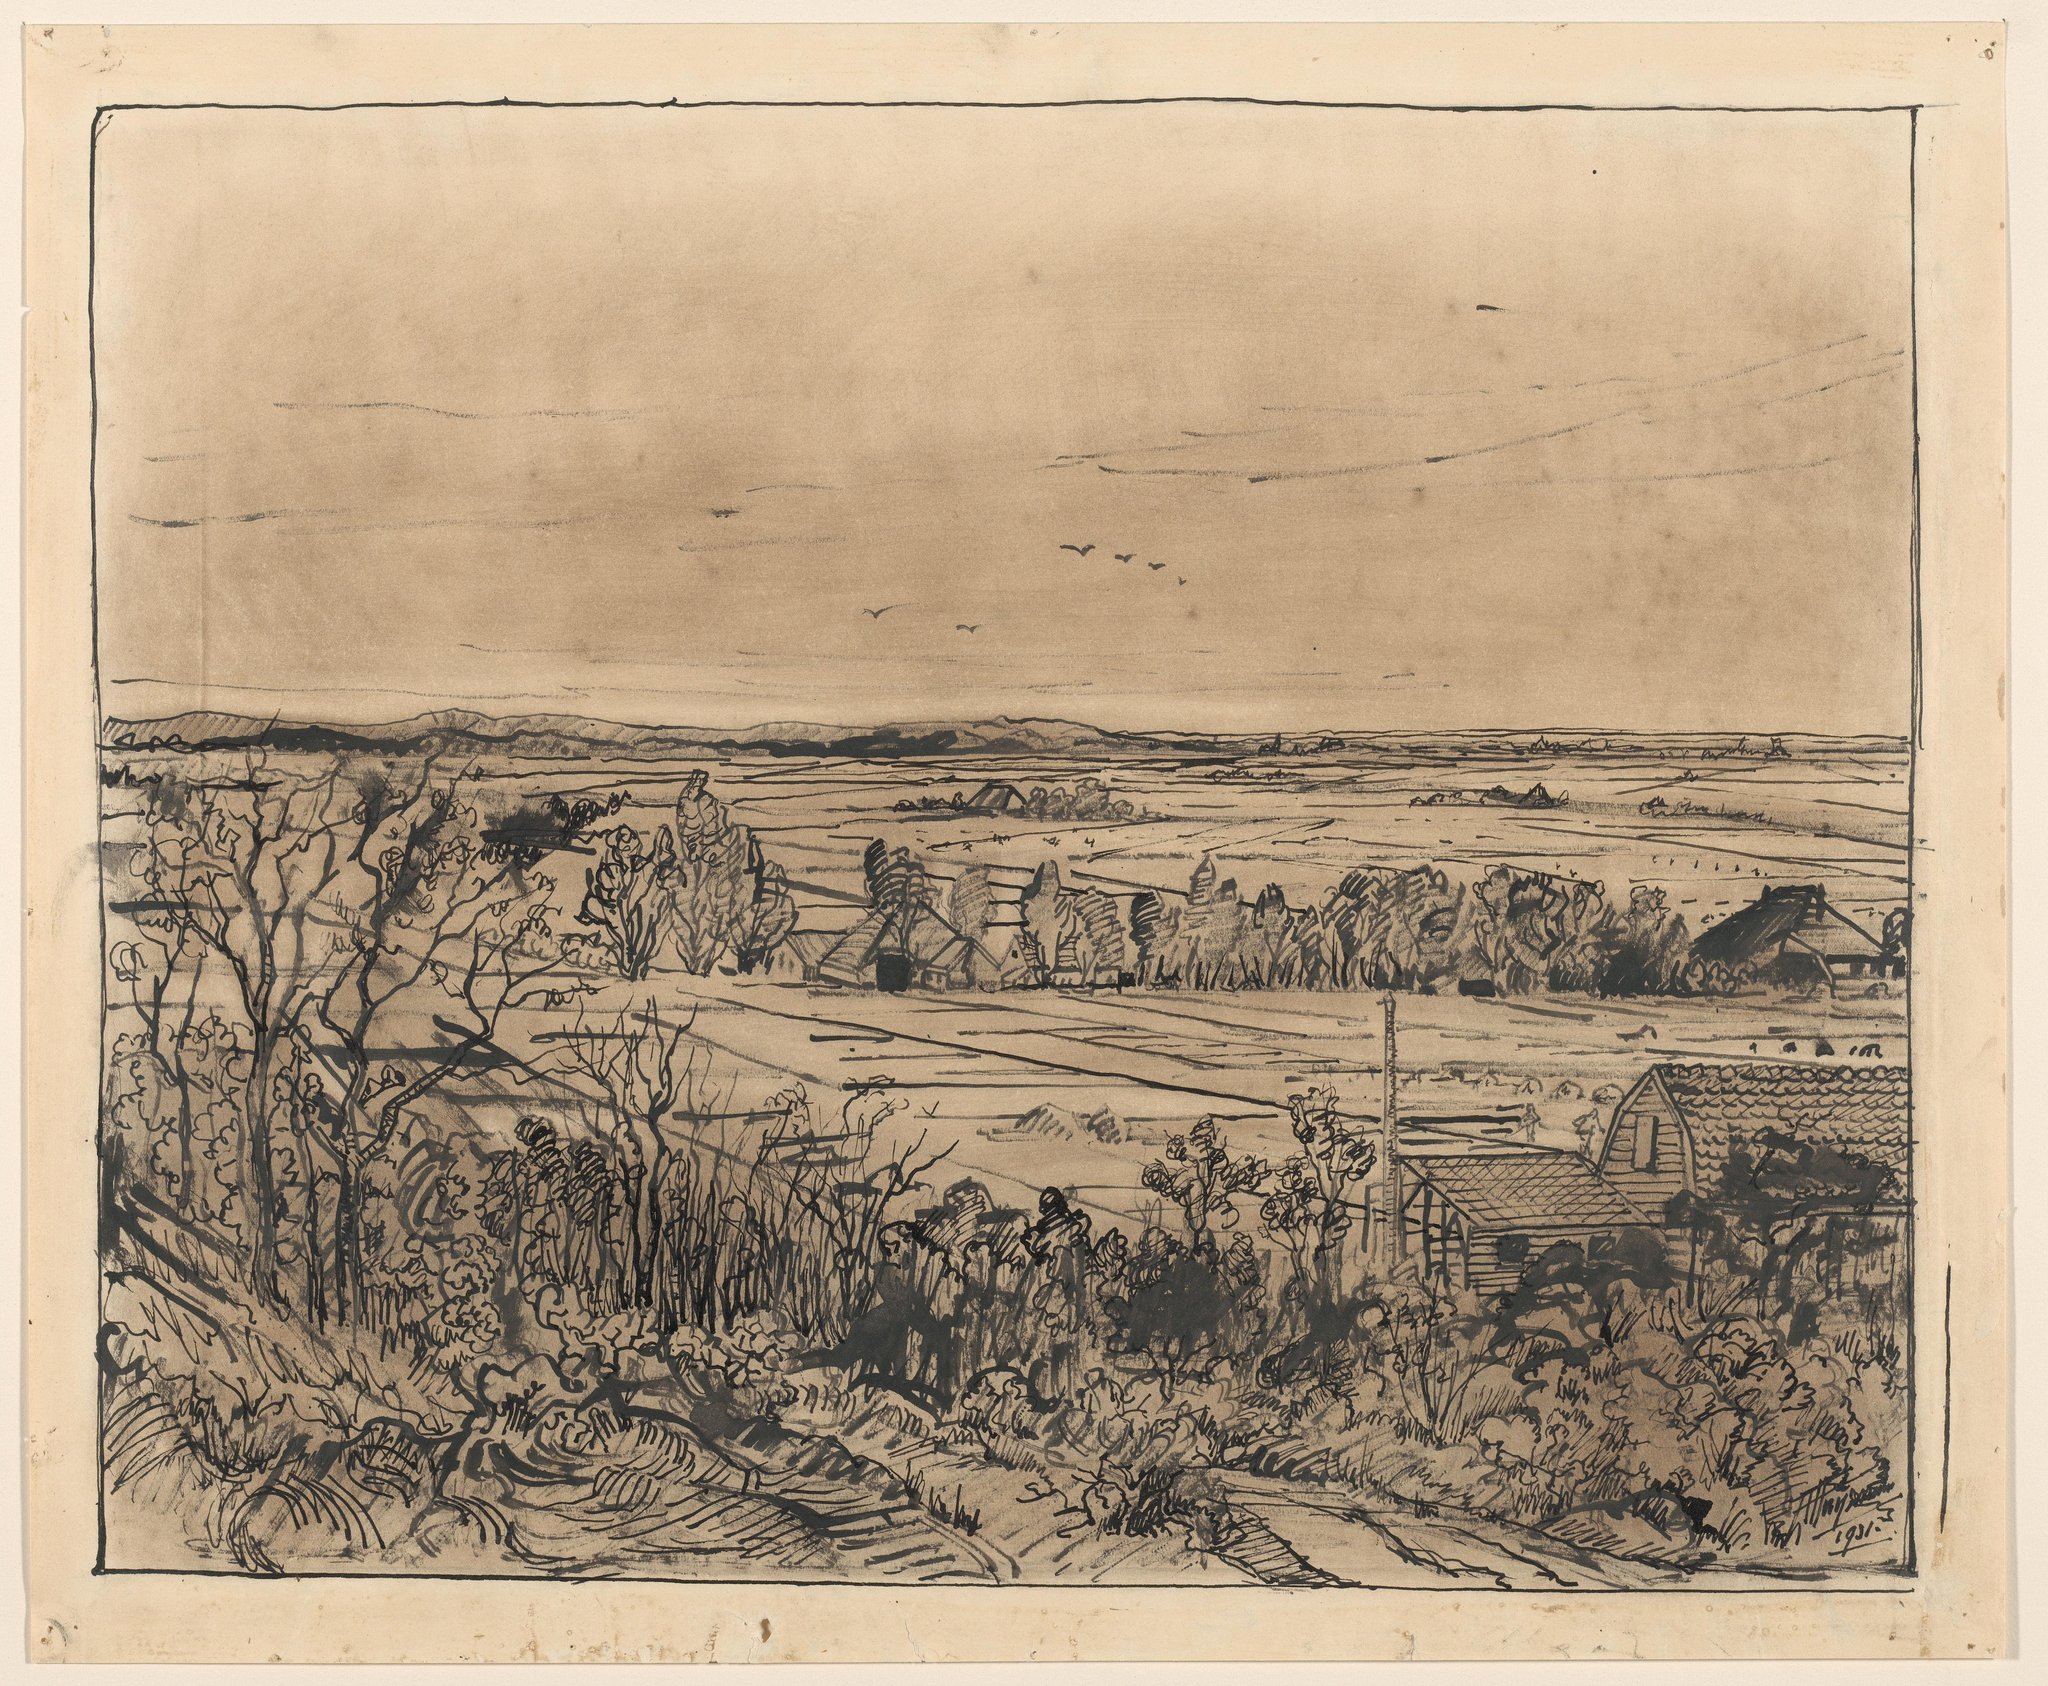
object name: drawing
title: Landschap met boerderijen gezien vanaf de duinen bij Bergen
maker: frans huysmans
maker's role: draughtsman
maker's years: 1885-1954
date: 1931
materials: ink, paper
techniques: brush, pen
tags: dunes (sea not visible); in the dunes, cultivated land, farm or solitary house in landscape